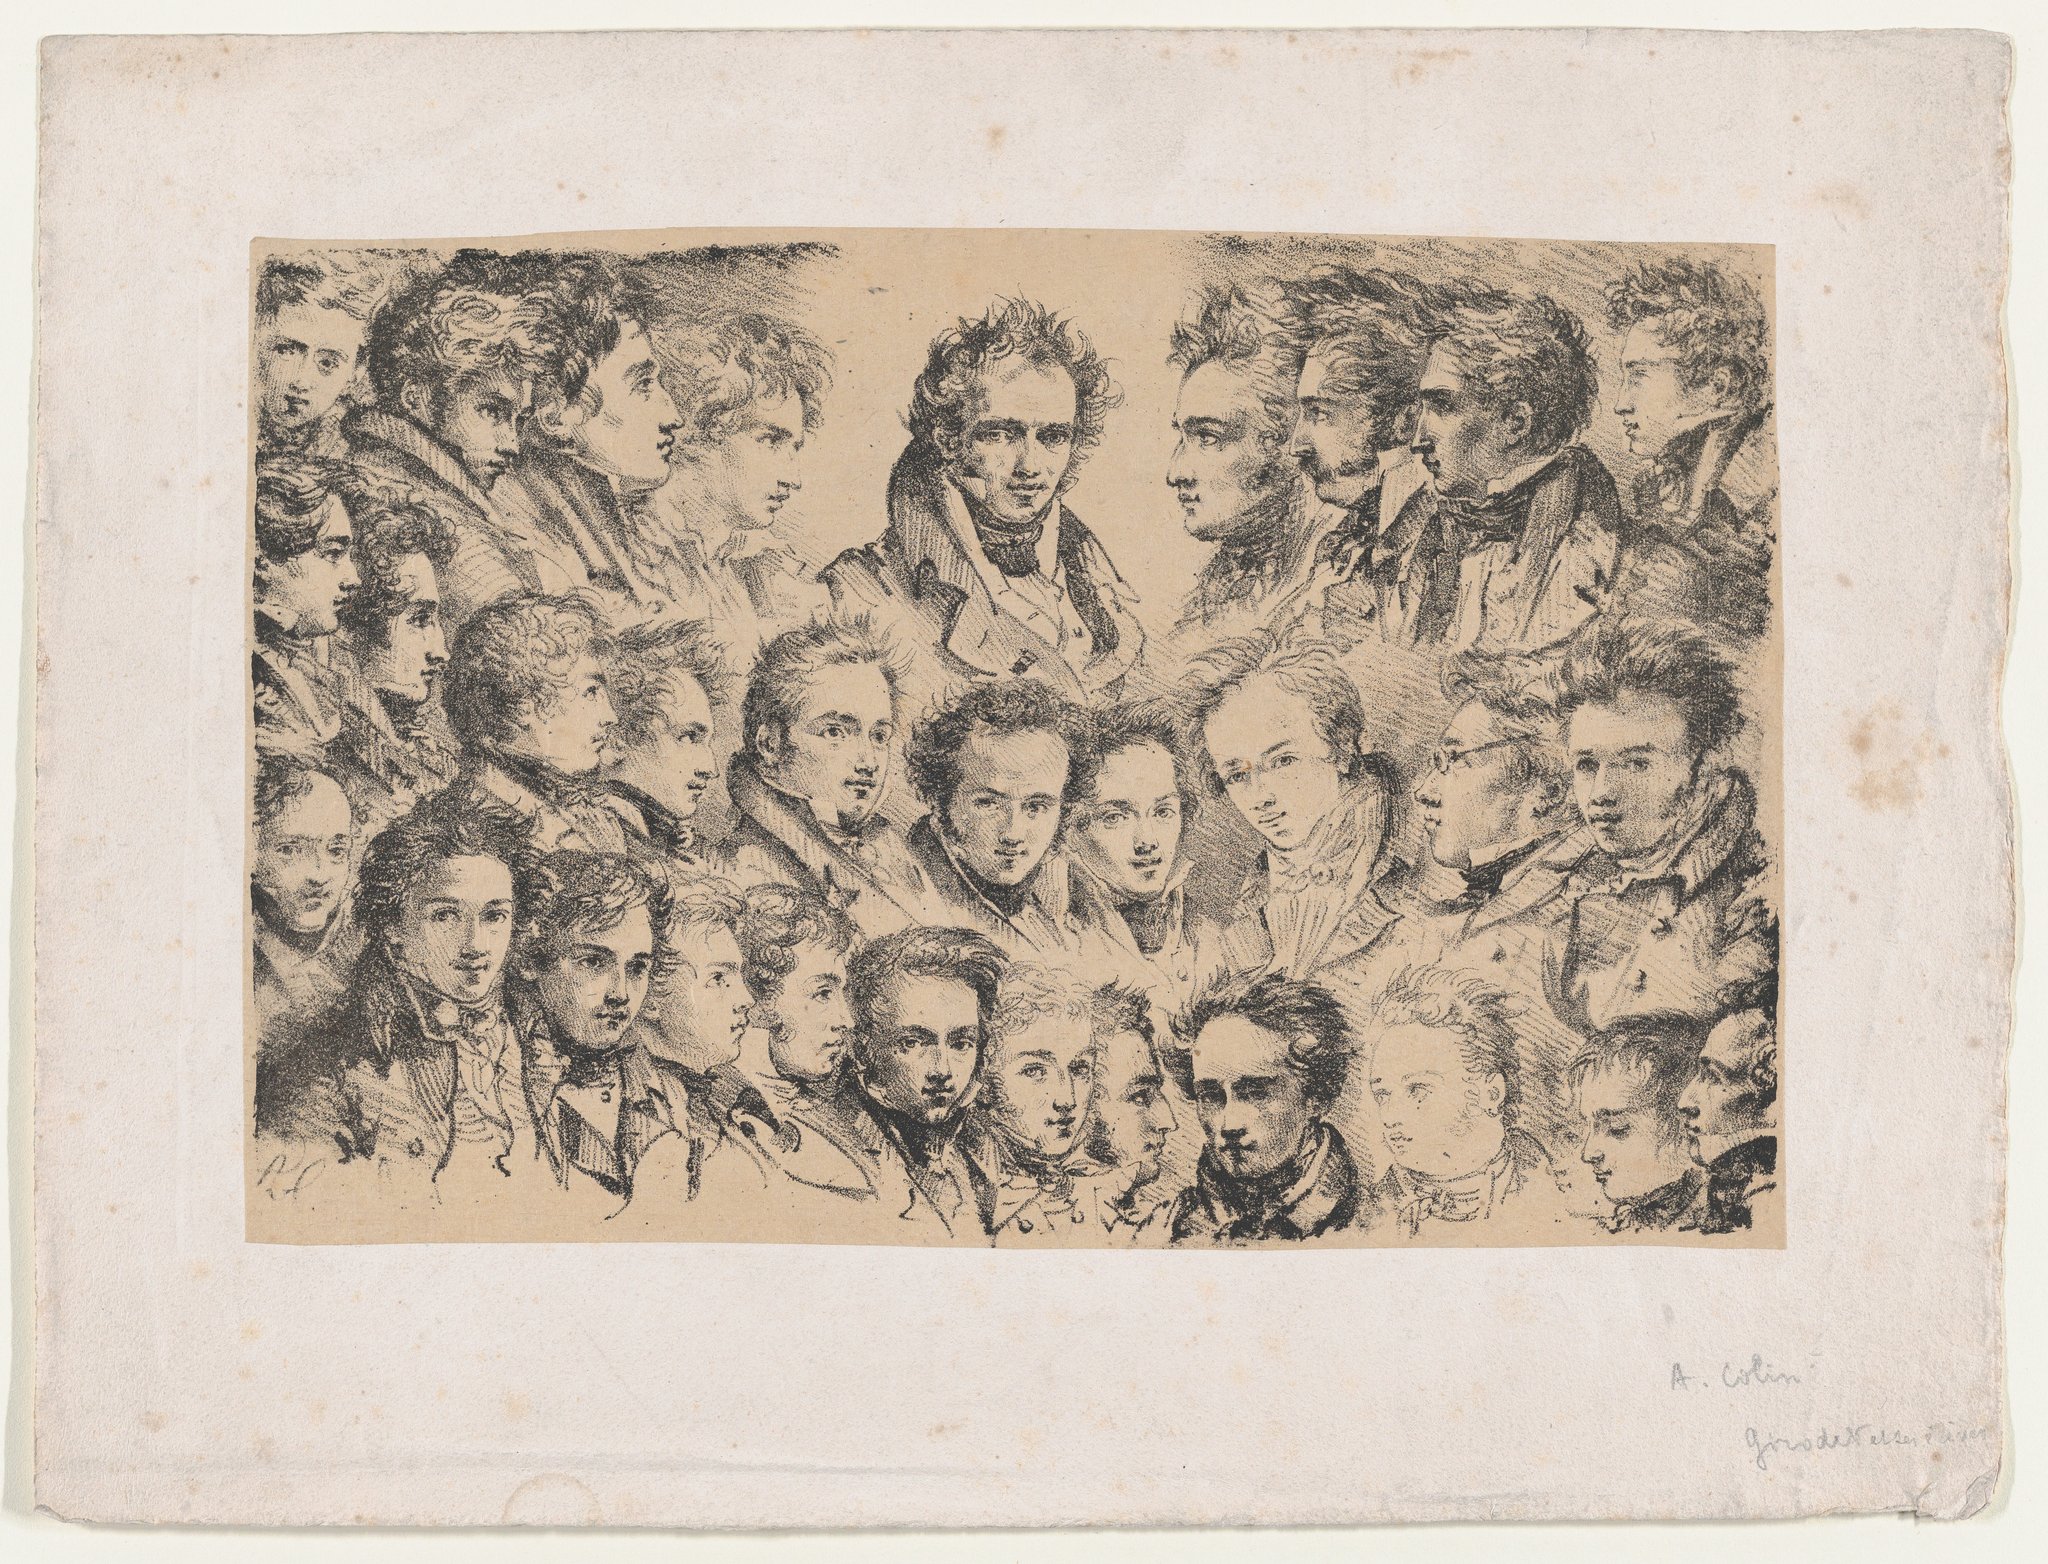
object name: print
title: Girodet and His Students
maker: alexandre-marie colin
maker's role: artist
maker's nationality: french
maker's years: 1798-1875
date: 1817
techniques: lithograph